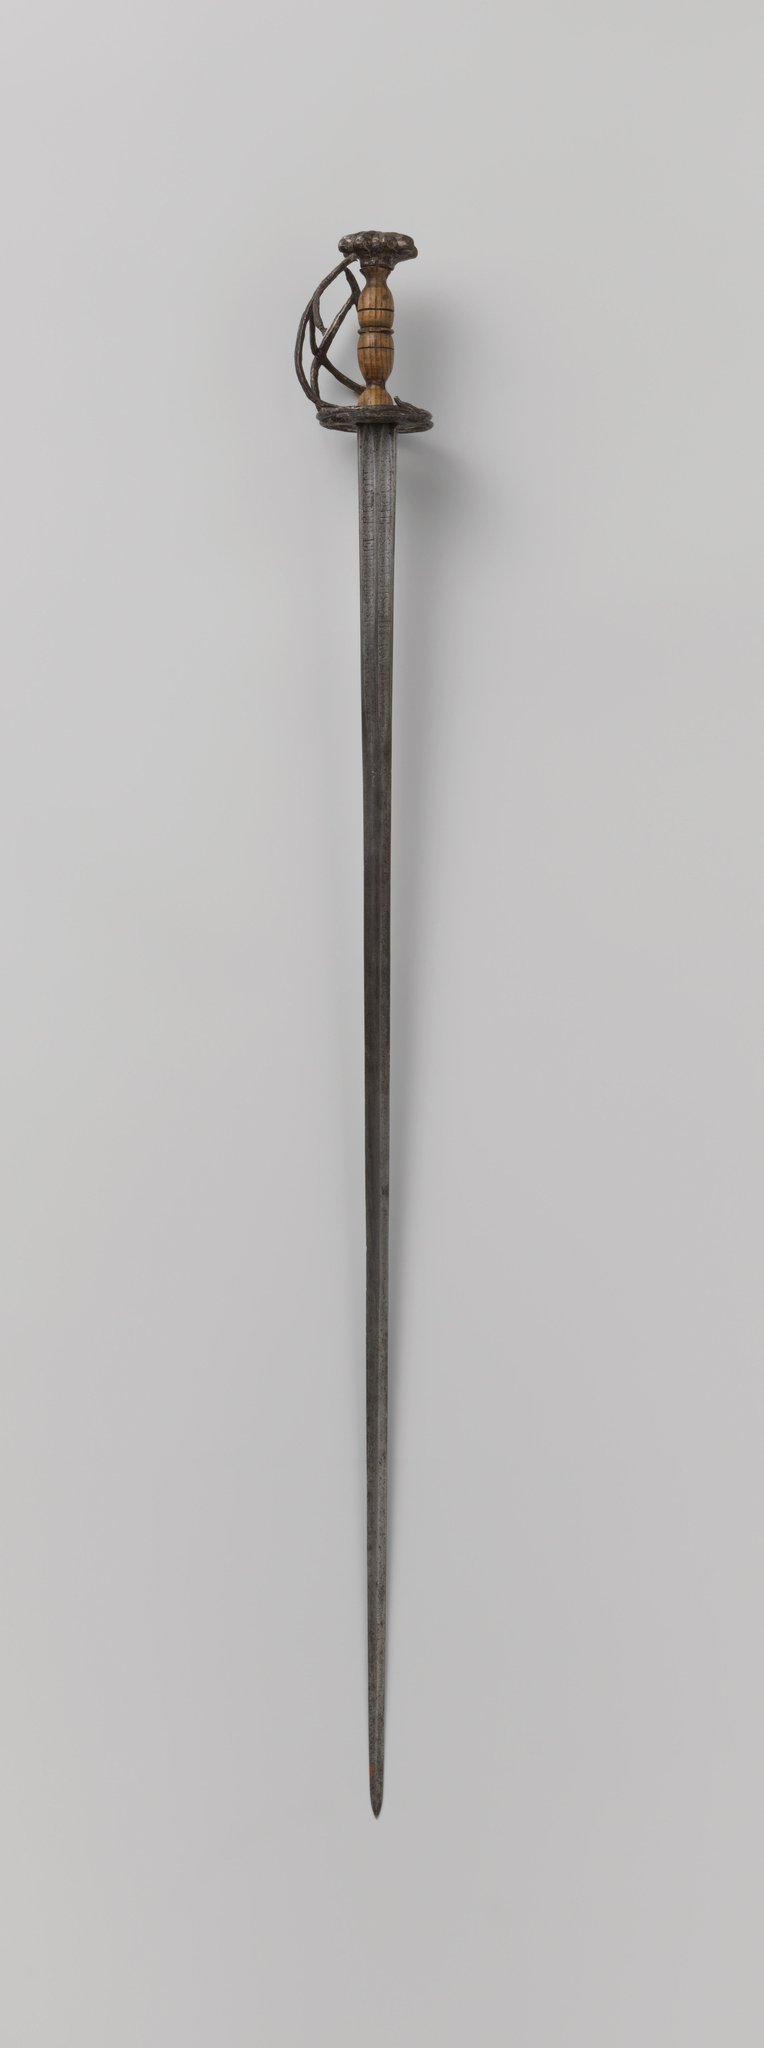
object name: sword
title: Degen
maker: Anonymous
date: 1575-1600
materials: iron, wood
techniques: incising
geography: western europe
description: Degen, brede platte kling aan het achtereinde met twee groeven waarin aan beide zijden: no me saques sin rason. No me enbaines sin honor. Het gevest is voorzien van een gesmeed ijzeren korf van op elkaar gelakte gebogen staven. Greep met ... houten omhulsel. Einde 16de eeuw. Lengte van de kling 1,01 m.